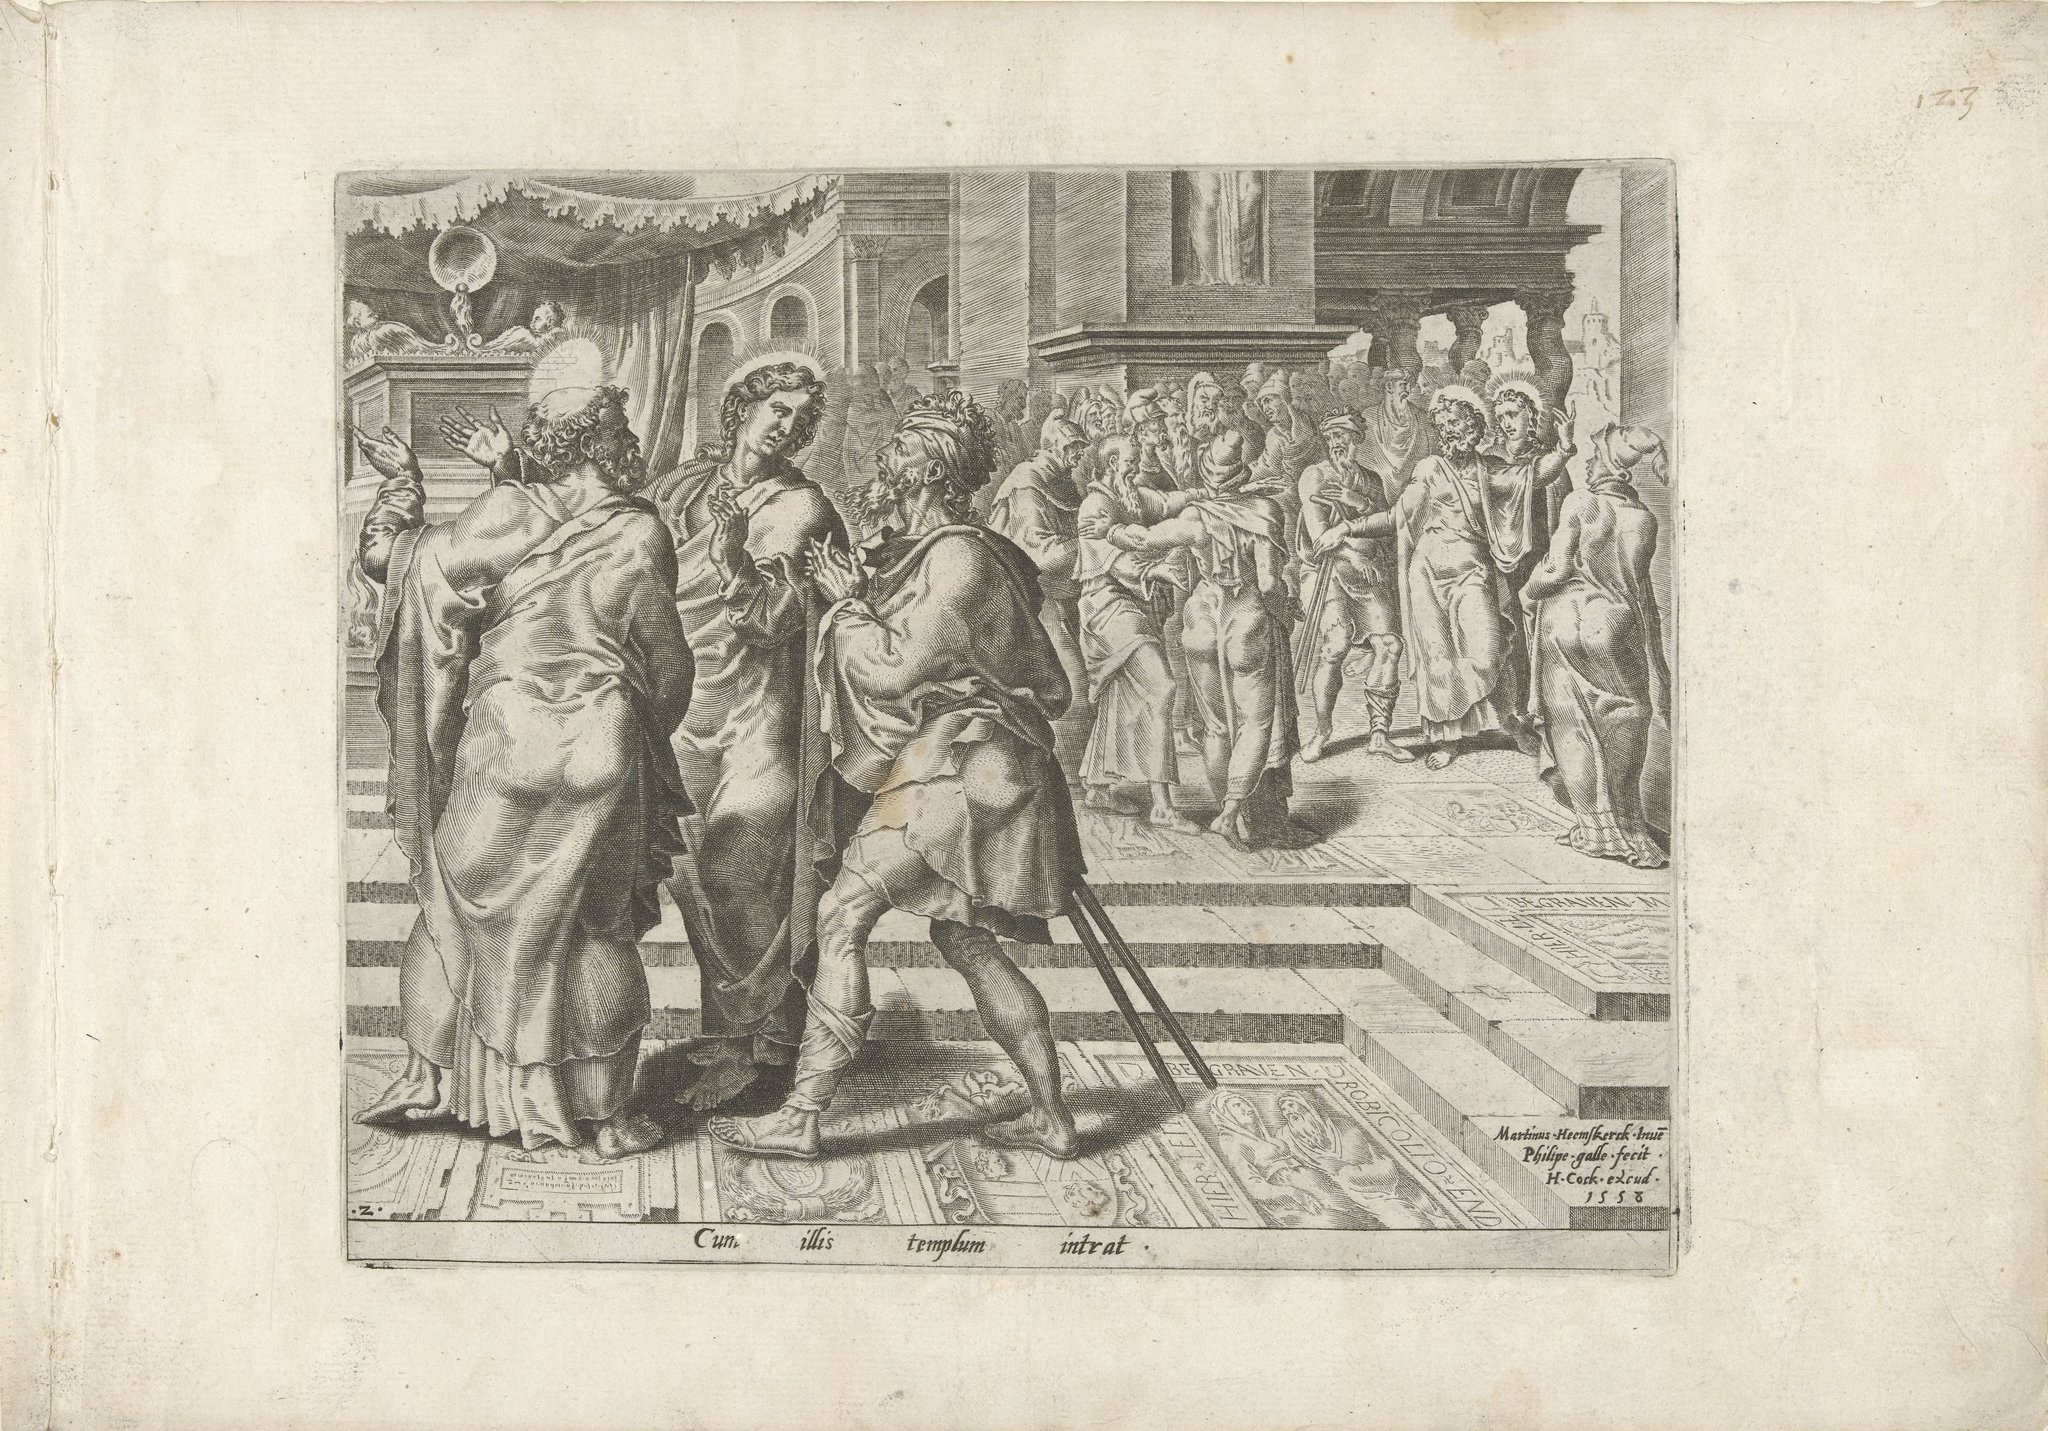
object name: print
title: Geschiedenis van Petrus en Johannes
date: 1558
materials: paper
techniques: engraving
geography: haarlem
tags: peter, john and the healed man enter the temple, where peter delivers a sermon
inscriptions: collector's mark: Lugt 2228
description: Petrus en Johannes lopen met de genezen bedelaar de tempel in. De gelovigen in de tempel zijn verbaast als zij in de bedelaar de verlamde man die altijd voor de deur van de tempel lag herkennen.